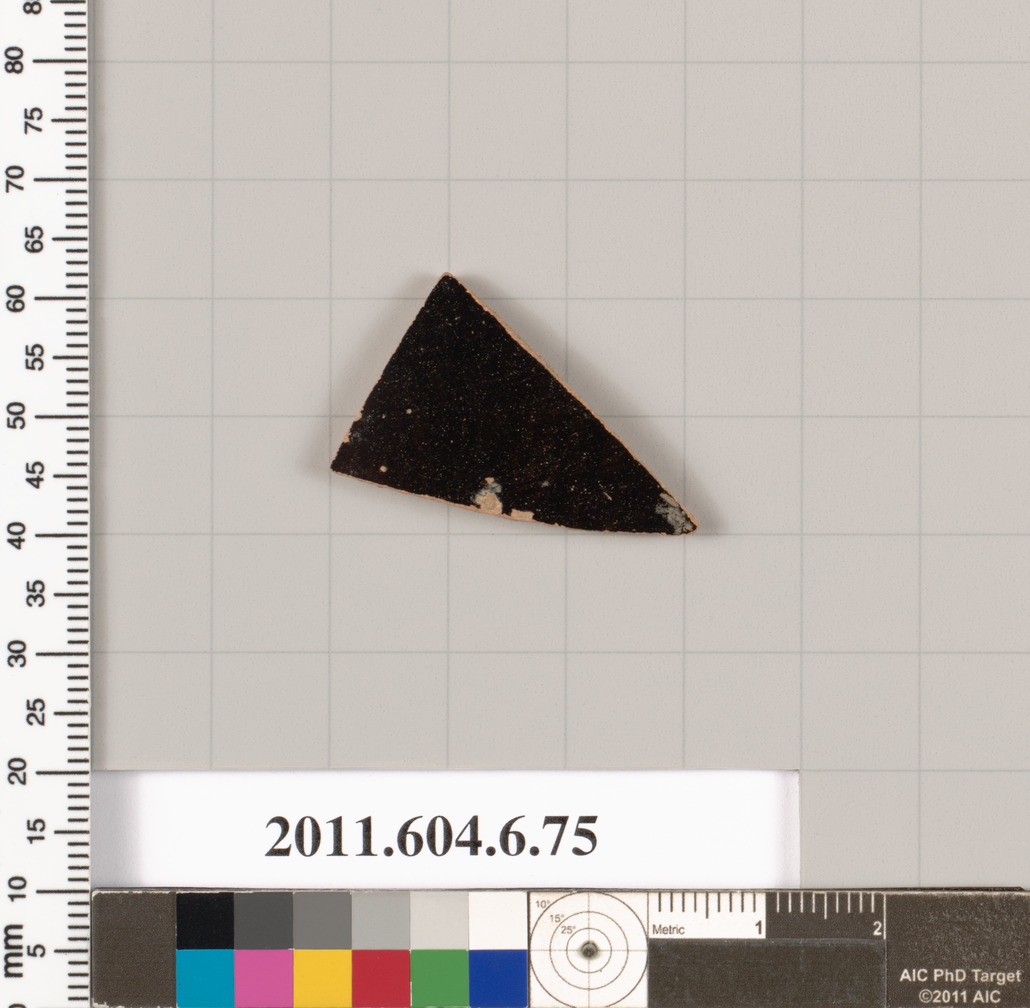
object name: undetermined closed shape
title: Terracotta fragment of a closed shape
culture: greek, attic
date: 600-401 BCE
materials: terracotta